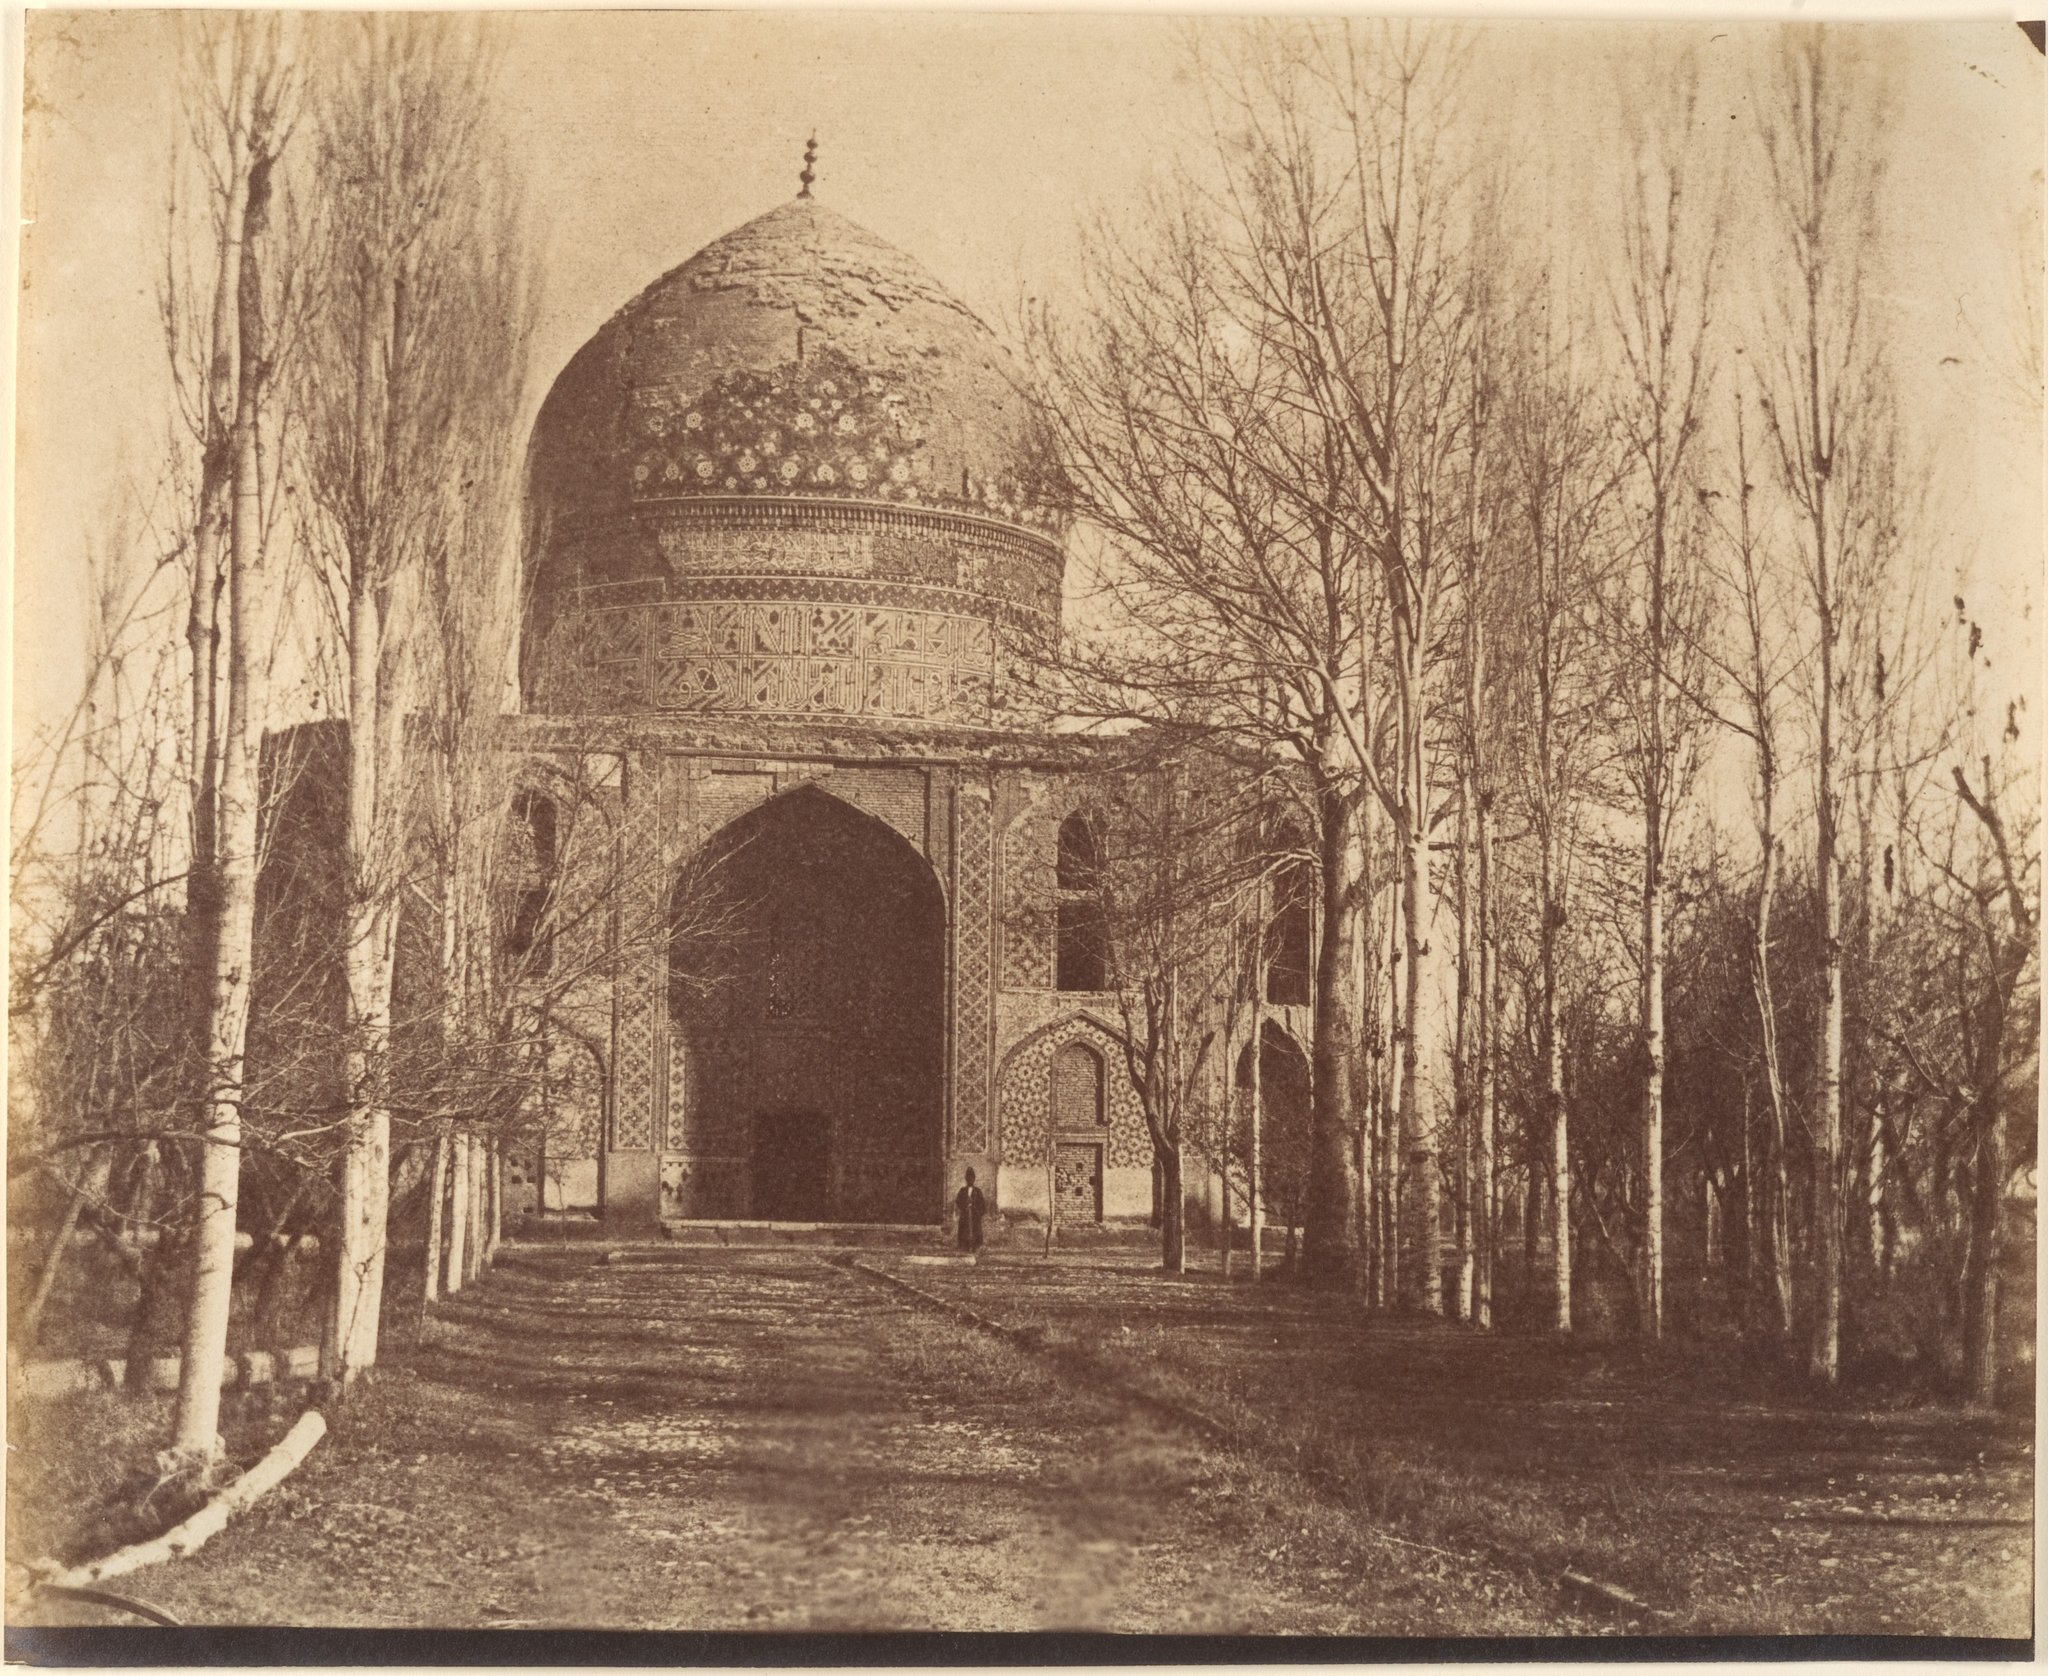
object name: photograph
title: [Tomb of Kogin Baba]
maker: luigi pesce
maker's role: artist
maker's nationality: italian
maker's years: 1818-1891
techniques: albumen silver print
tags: architecture,tombs